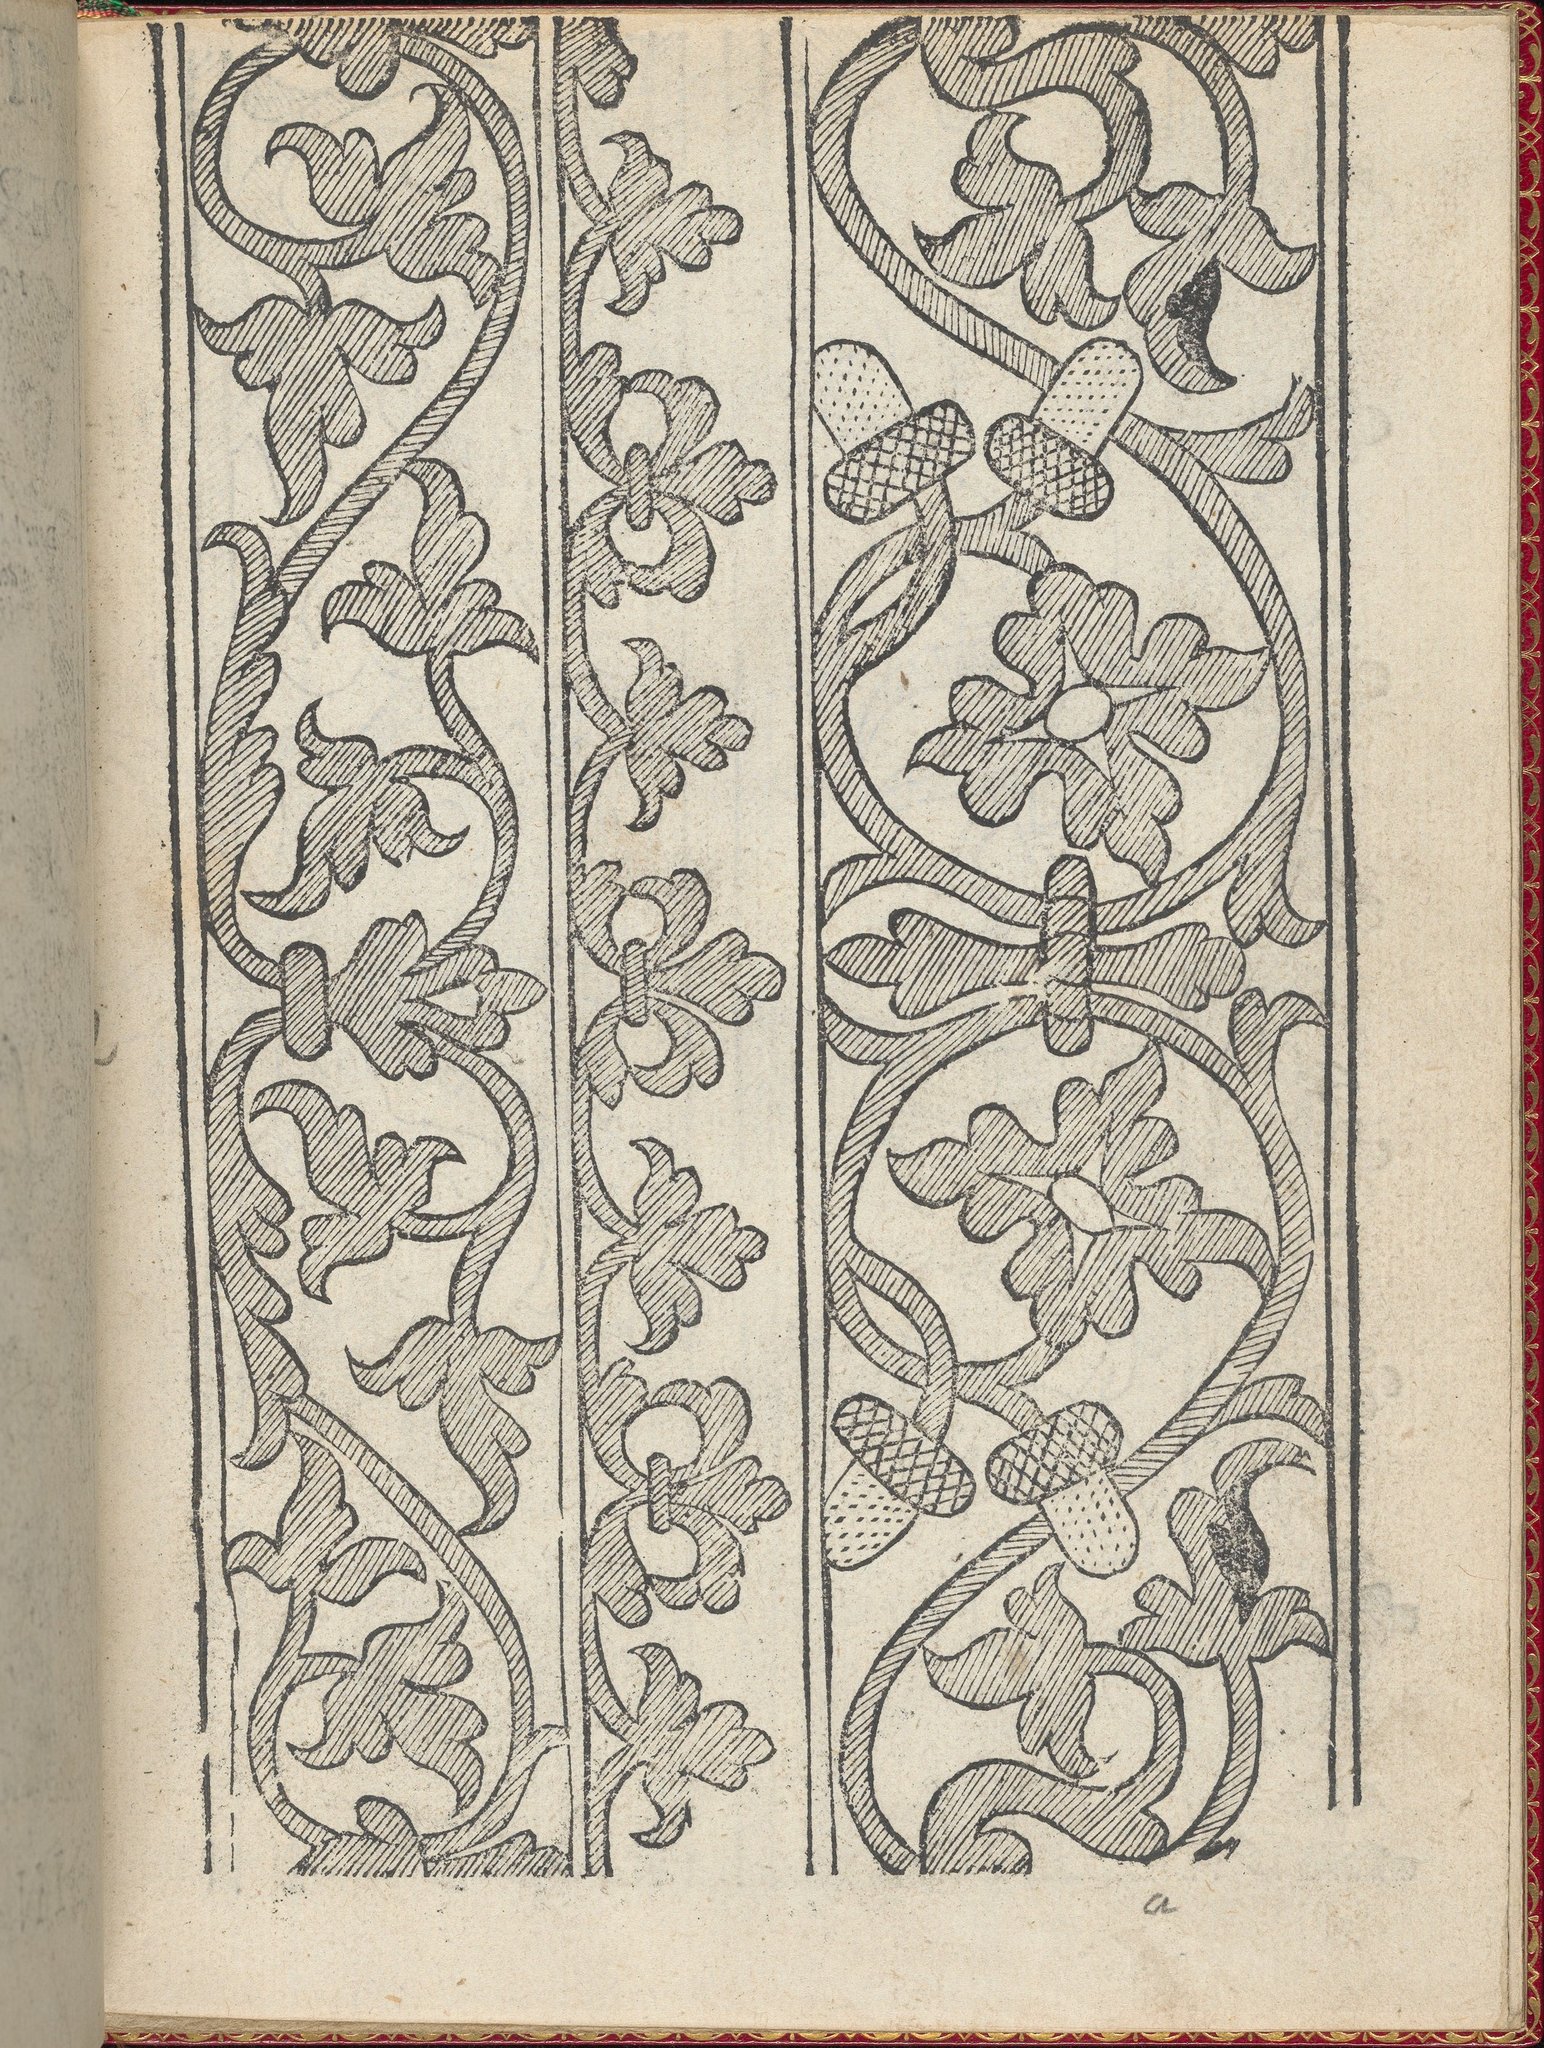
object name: book print ornament architecture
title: Il Monte. Opera Nova di Recami, page 2 (recto)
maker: giovanni antonio bindoni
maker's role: designer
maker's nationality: italian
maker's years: 1500-1650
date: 1557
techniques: woodcut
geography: italy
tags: flowers,acorns,vines